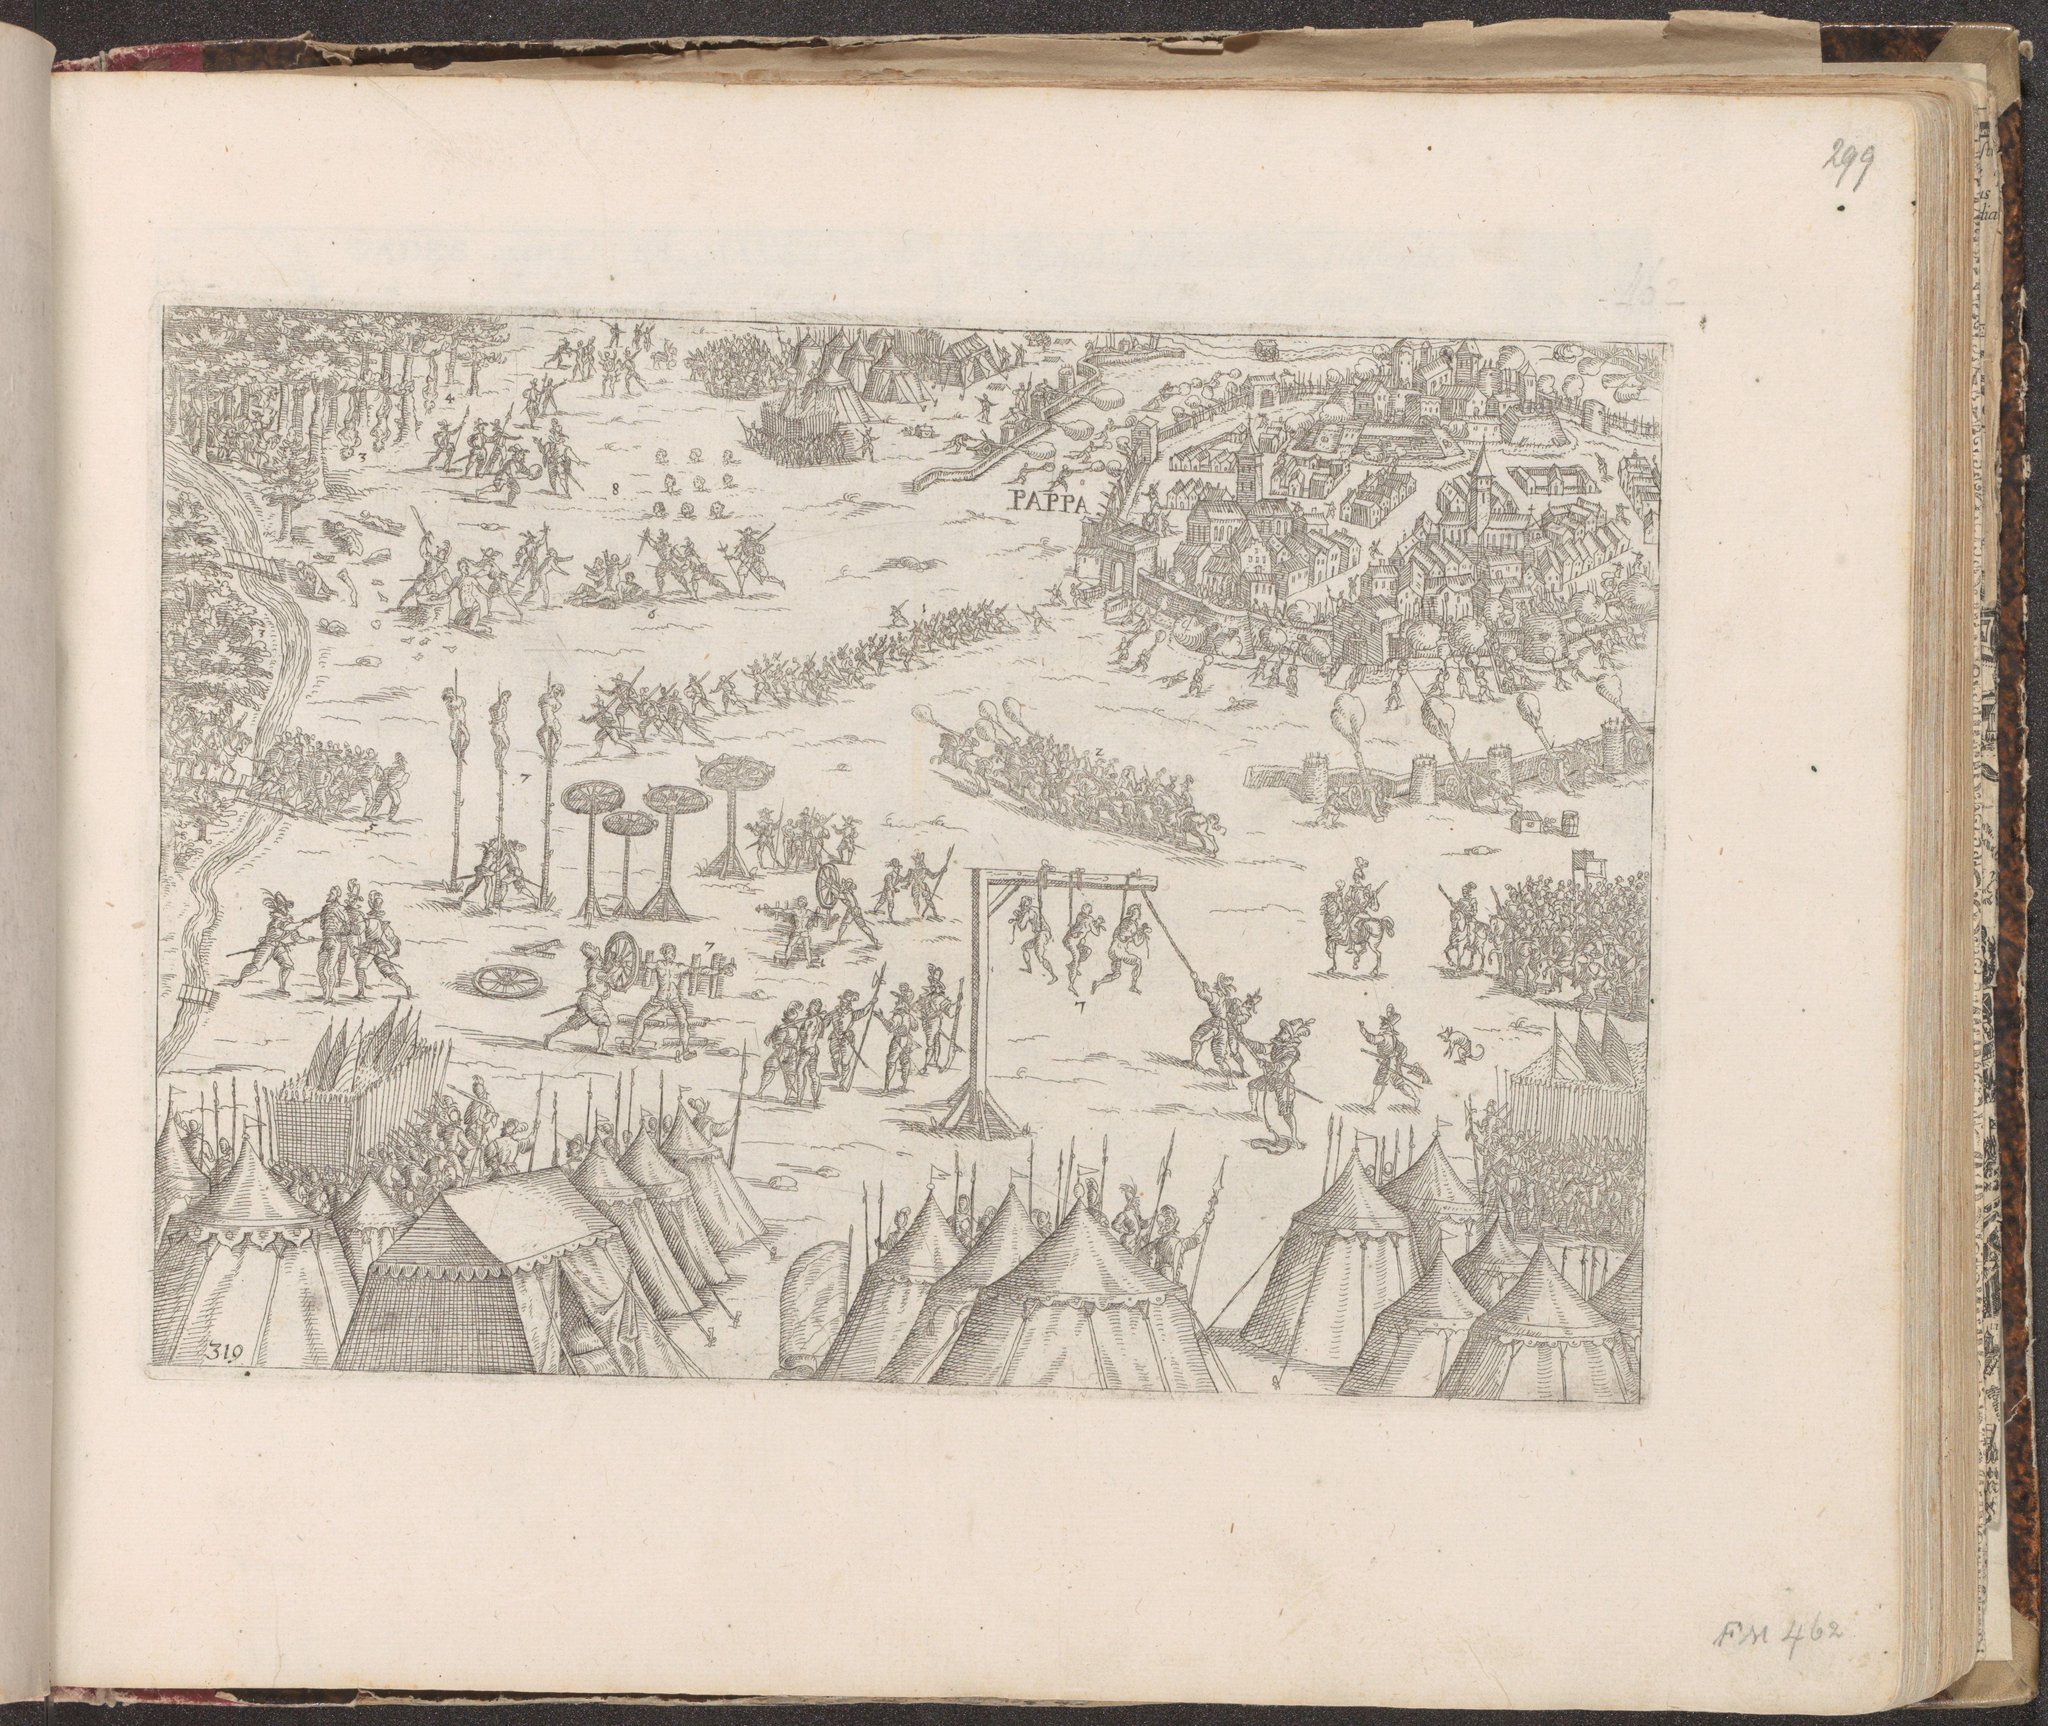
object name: print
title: Serie 11: Varia Buitenlandse Gebeurtenissen, 1571-1631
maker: frans hogenberg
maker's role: print maker, publisher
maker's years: 1538-1590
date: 1597-1599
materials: paper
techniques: etching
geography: cologne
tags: capture of city (after the siege), violent death, being killed; being mishandled and maltreated; seeking death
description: Verovering van Papa in Hongarije, 19 augustus 1597. Belegering van de stad Papa, voor de stad een legerkamp waar allerlei verminkingen en terechtstellingen plaatsvinden. Verschillende elementen in de voorstelling aangeduid met cijfers maar een legenda met een verklaring ontbreekt. Zonder onderschrift. Linksonder genummerd: 319. De prent maakt deel uit van een album.